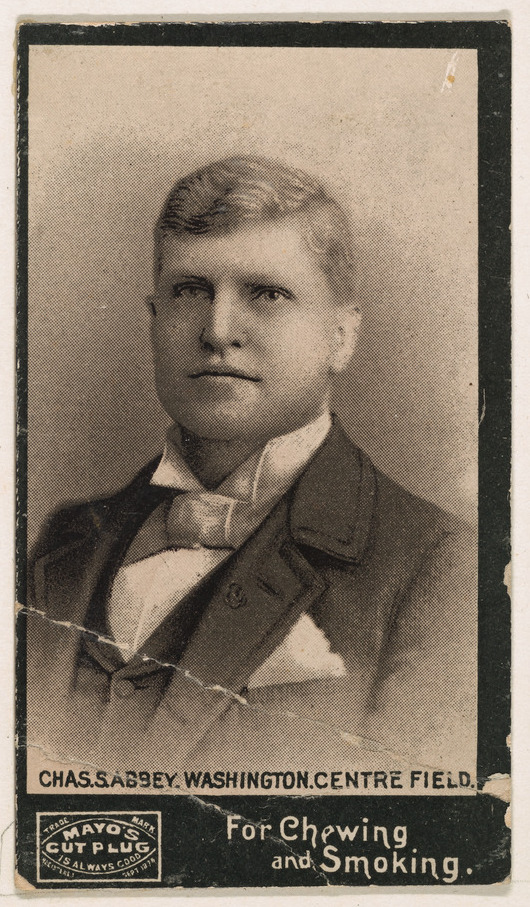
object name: print, baseball card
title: Charles S. Abbey, Center Field, Washington, from Mayo's Cut Plug Baseball series (N300)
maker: p.h. mayo & brother, richmond, virginia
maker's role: publisher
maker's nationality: american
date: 1895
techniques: lithography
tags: men,portraits,baseball,athletes